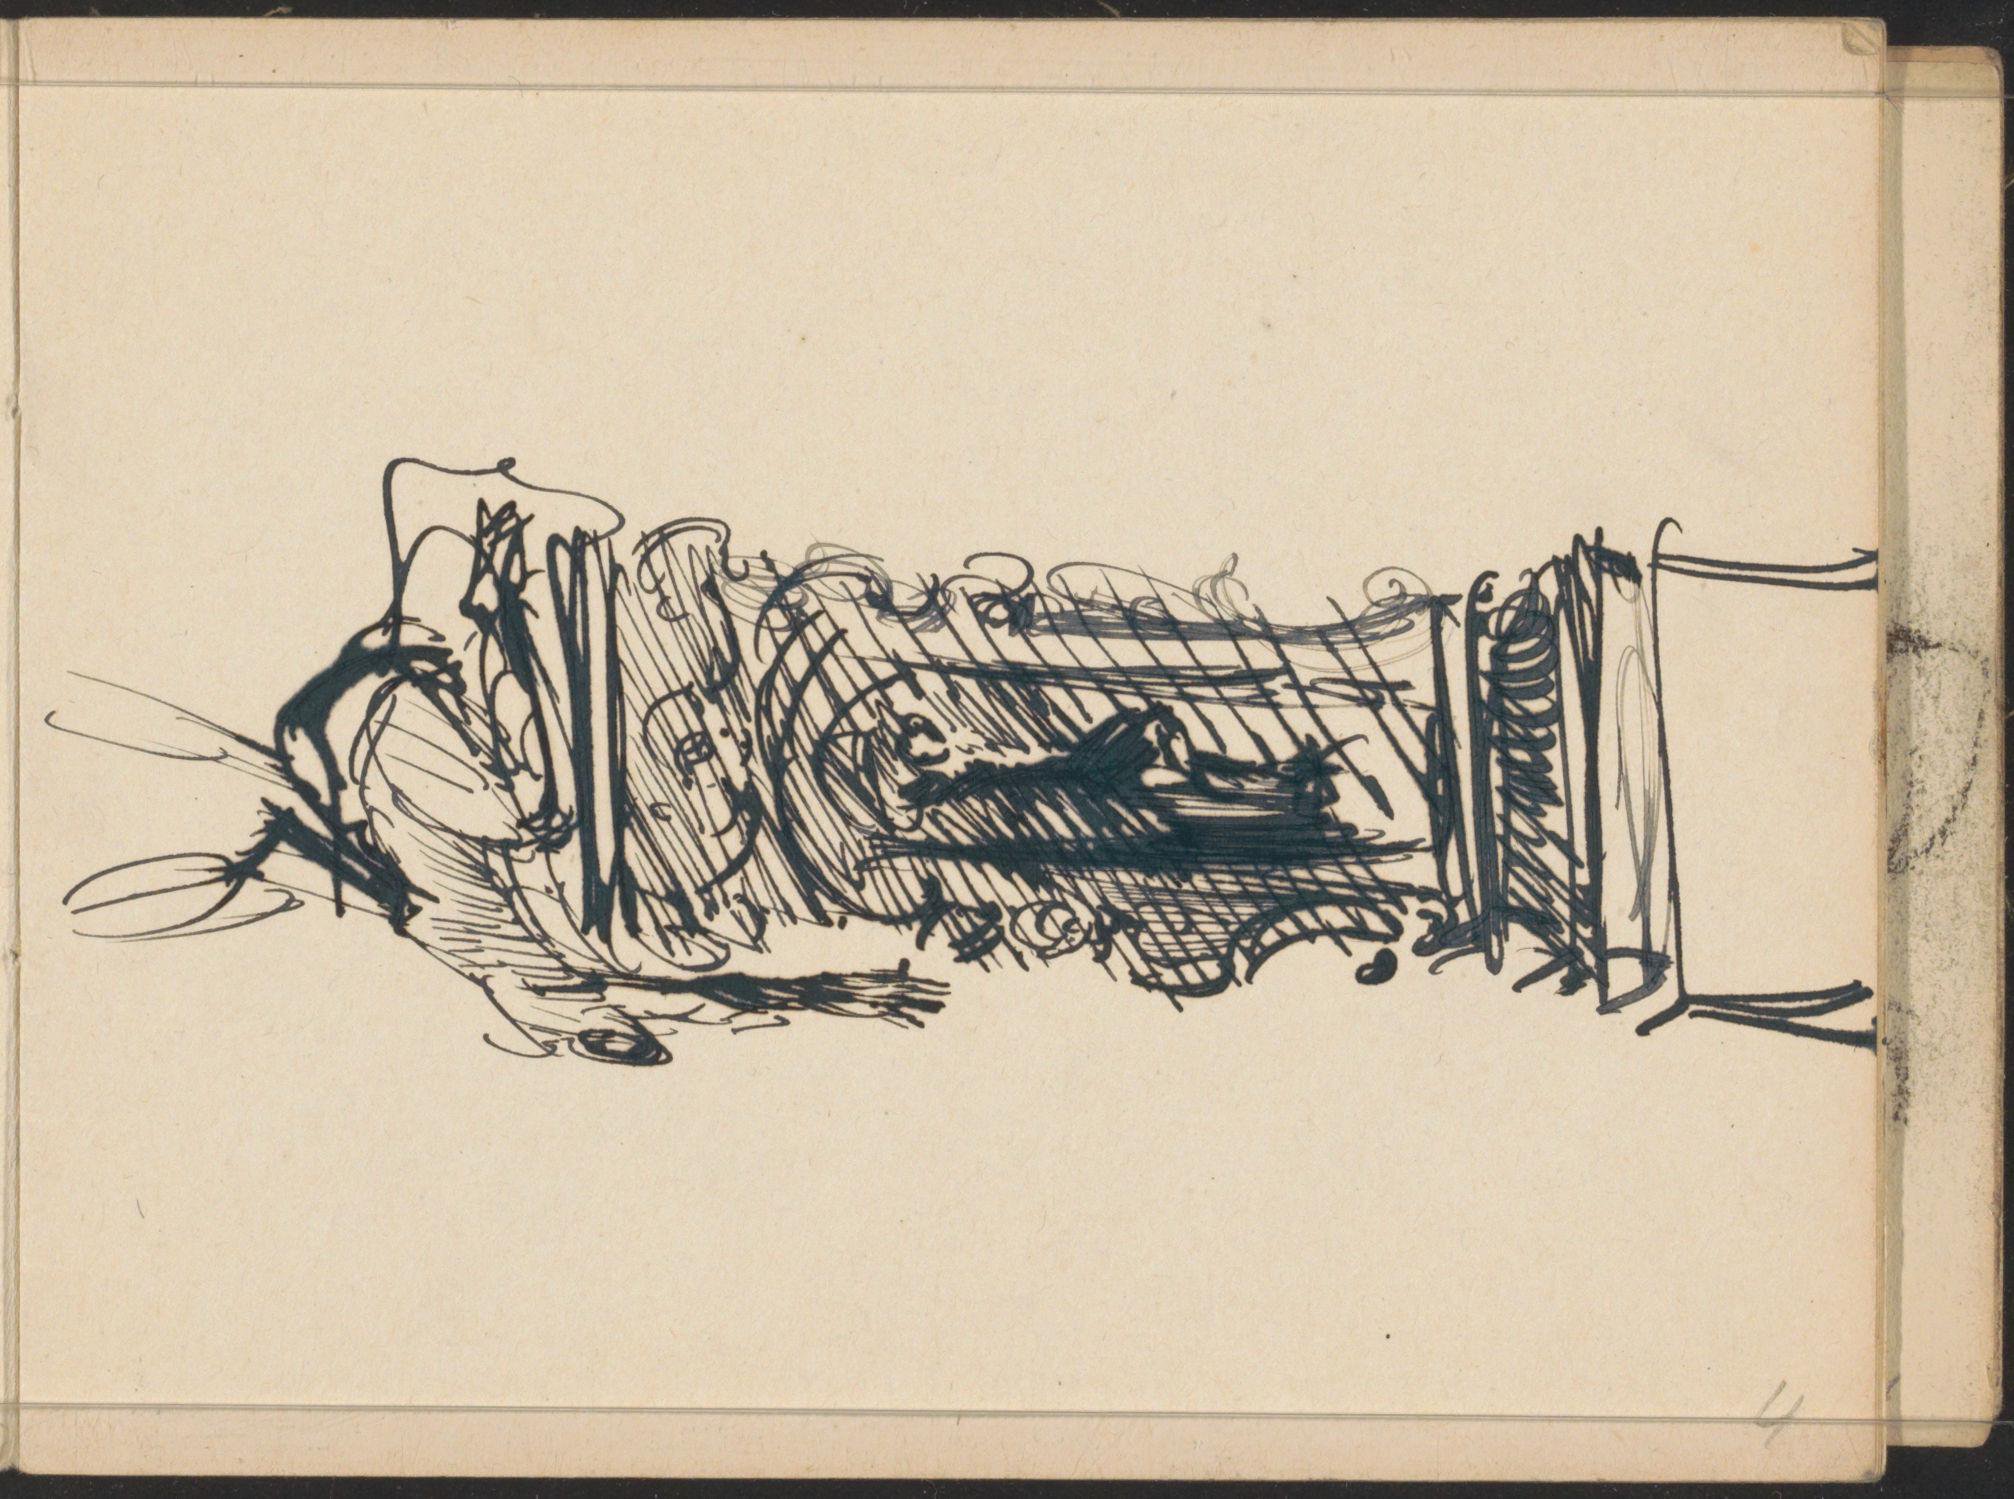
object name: sketchbook leaf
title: Sokkel van het beeld van Perseus en Medusa op het Piazza della Signoria te Florence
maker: isaac israels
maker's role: draughtsman, painter, print maker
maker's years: 1865-1934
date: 1923-1934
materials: ink, paper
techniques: pen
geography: florence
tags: perseus beheading medusa, monument, statue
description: Mogelijk een voorstudie voor Israels' schilderij 'Piazza della Signoria te Florence', ca. 1927, particuliere collectie.